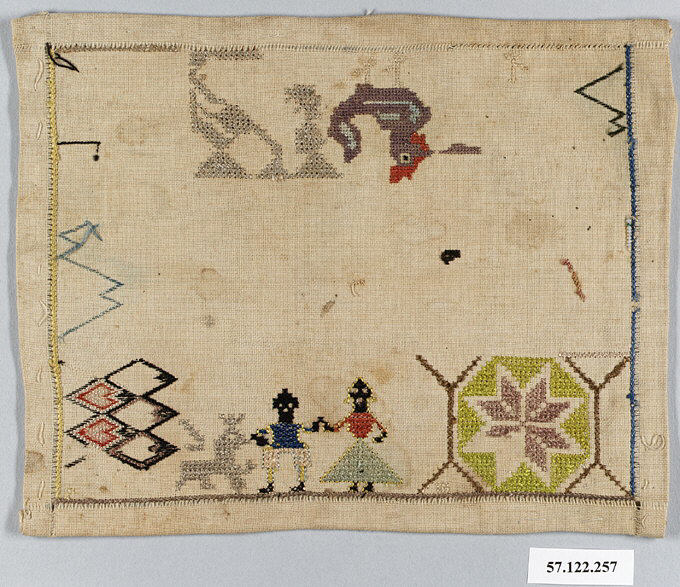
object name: sampler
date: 1801-1900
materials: cotton, silk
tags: chickens,boys,girls